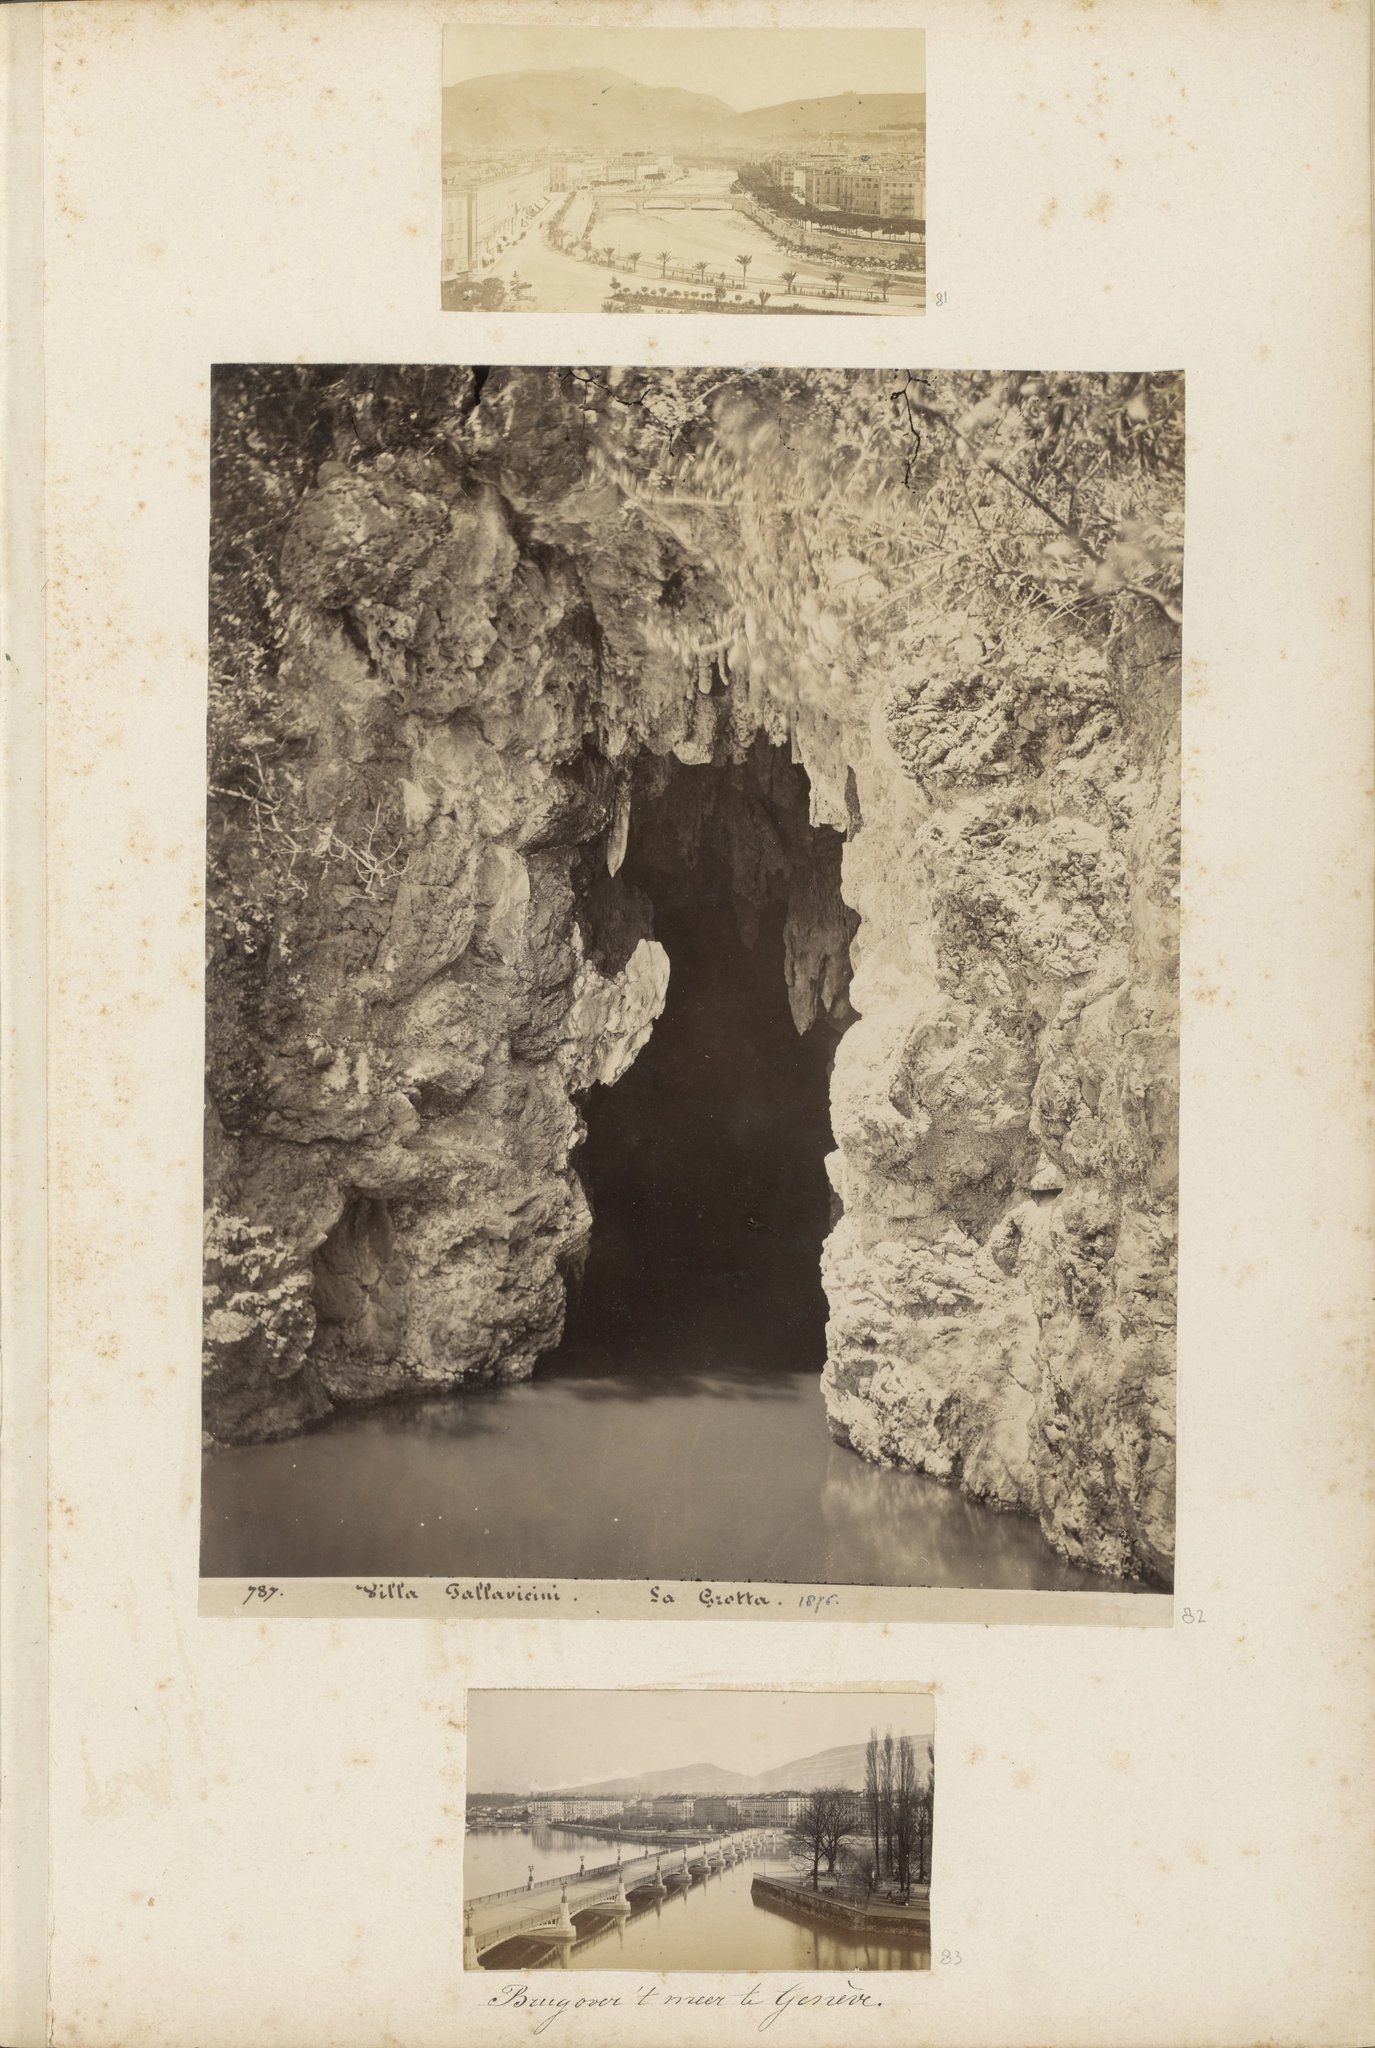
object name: album leaf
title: Gezicht op een stad aan een rivier, mogelijk in Frankrijk, Zwitserland of Italië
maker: Anonymous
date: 1870-1880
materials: paper, photographic support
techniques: albumen print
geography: europe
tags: river, prospect of city, town panorama, silhouette of city, europe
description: Onderdeel van Fotoalbum van Robert Daniel Crommelin (1841-1907).